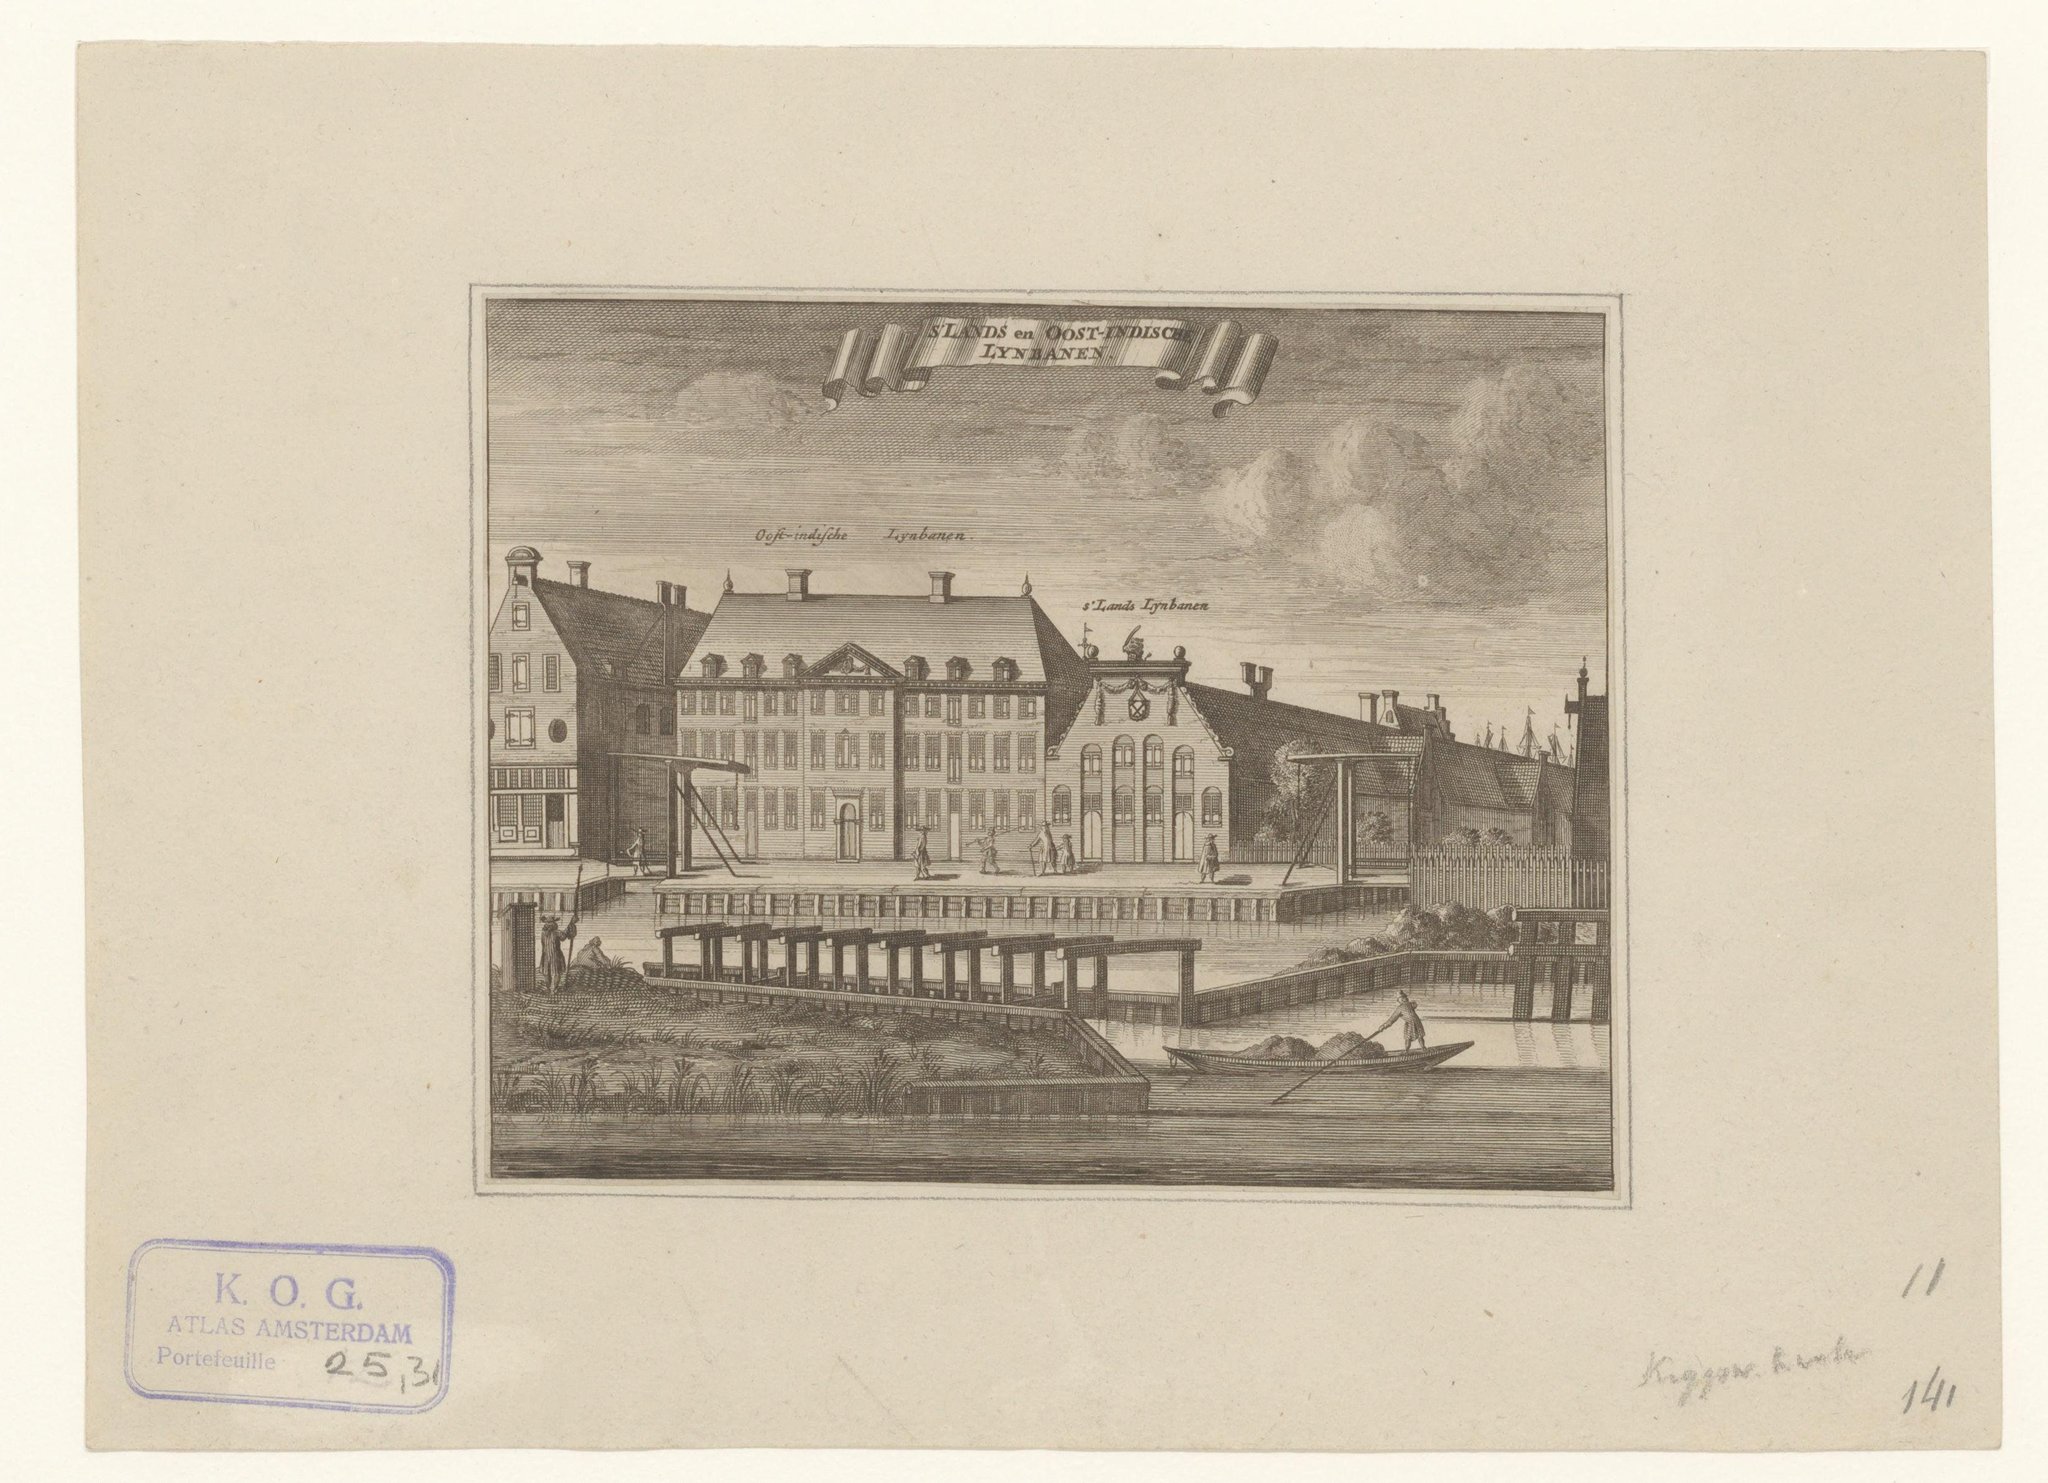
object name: print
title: Gezicht op de lijnbanen van de VOC en de Admiraliteit op Oostenburg te Amsterdam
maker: Anonymous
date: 1693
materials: paper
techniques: engraving, etching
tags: ropery, rope-walk, canals, waters (in city) (+ city(-scape) with figures, staffage), street (+ city(-scape) with figures, staffage)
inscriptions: collector's mark: ‘25.31’ Lugt 1641b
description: Huidige staat van prent ook gebruikt in: Commelin, Caspar. Beschryvinge van Amsterdam, zynde een naukeurige verhandelinge van desselfs eerste oorspronk uyt (…). 2 delen. 2e druk. Amsterdam: Andries van Damme, Johannes Ratelband, weduwe A. van Aaltwyk en Hermanus Uytwerf, 1726. Eerdere staat van prent (RP-P-AO-25-60-1) ook gebruikt in: Commelin, Caspar. Beschryvinge van Amsterdam, desselfs eerste oorspronk uyt den Huyse (…). 2 delen. Amsterdam: Abraham Wolfgang, Gillis Janssonius van Waesberge, Johannes Janssonius van Waesberge II, weduwe Dirk Boom I, Hendrick Boom en Rembertus Goethals, 1693. En in: Commelin, Caspar. Beschryvinge van Amsterdam, zynde een naukeurige verhandelinge van desselfs eerste oorspronk uyt (…). 2 delen. Amsterdam: weduwe Aart Dircksz Oossaan, 1694.